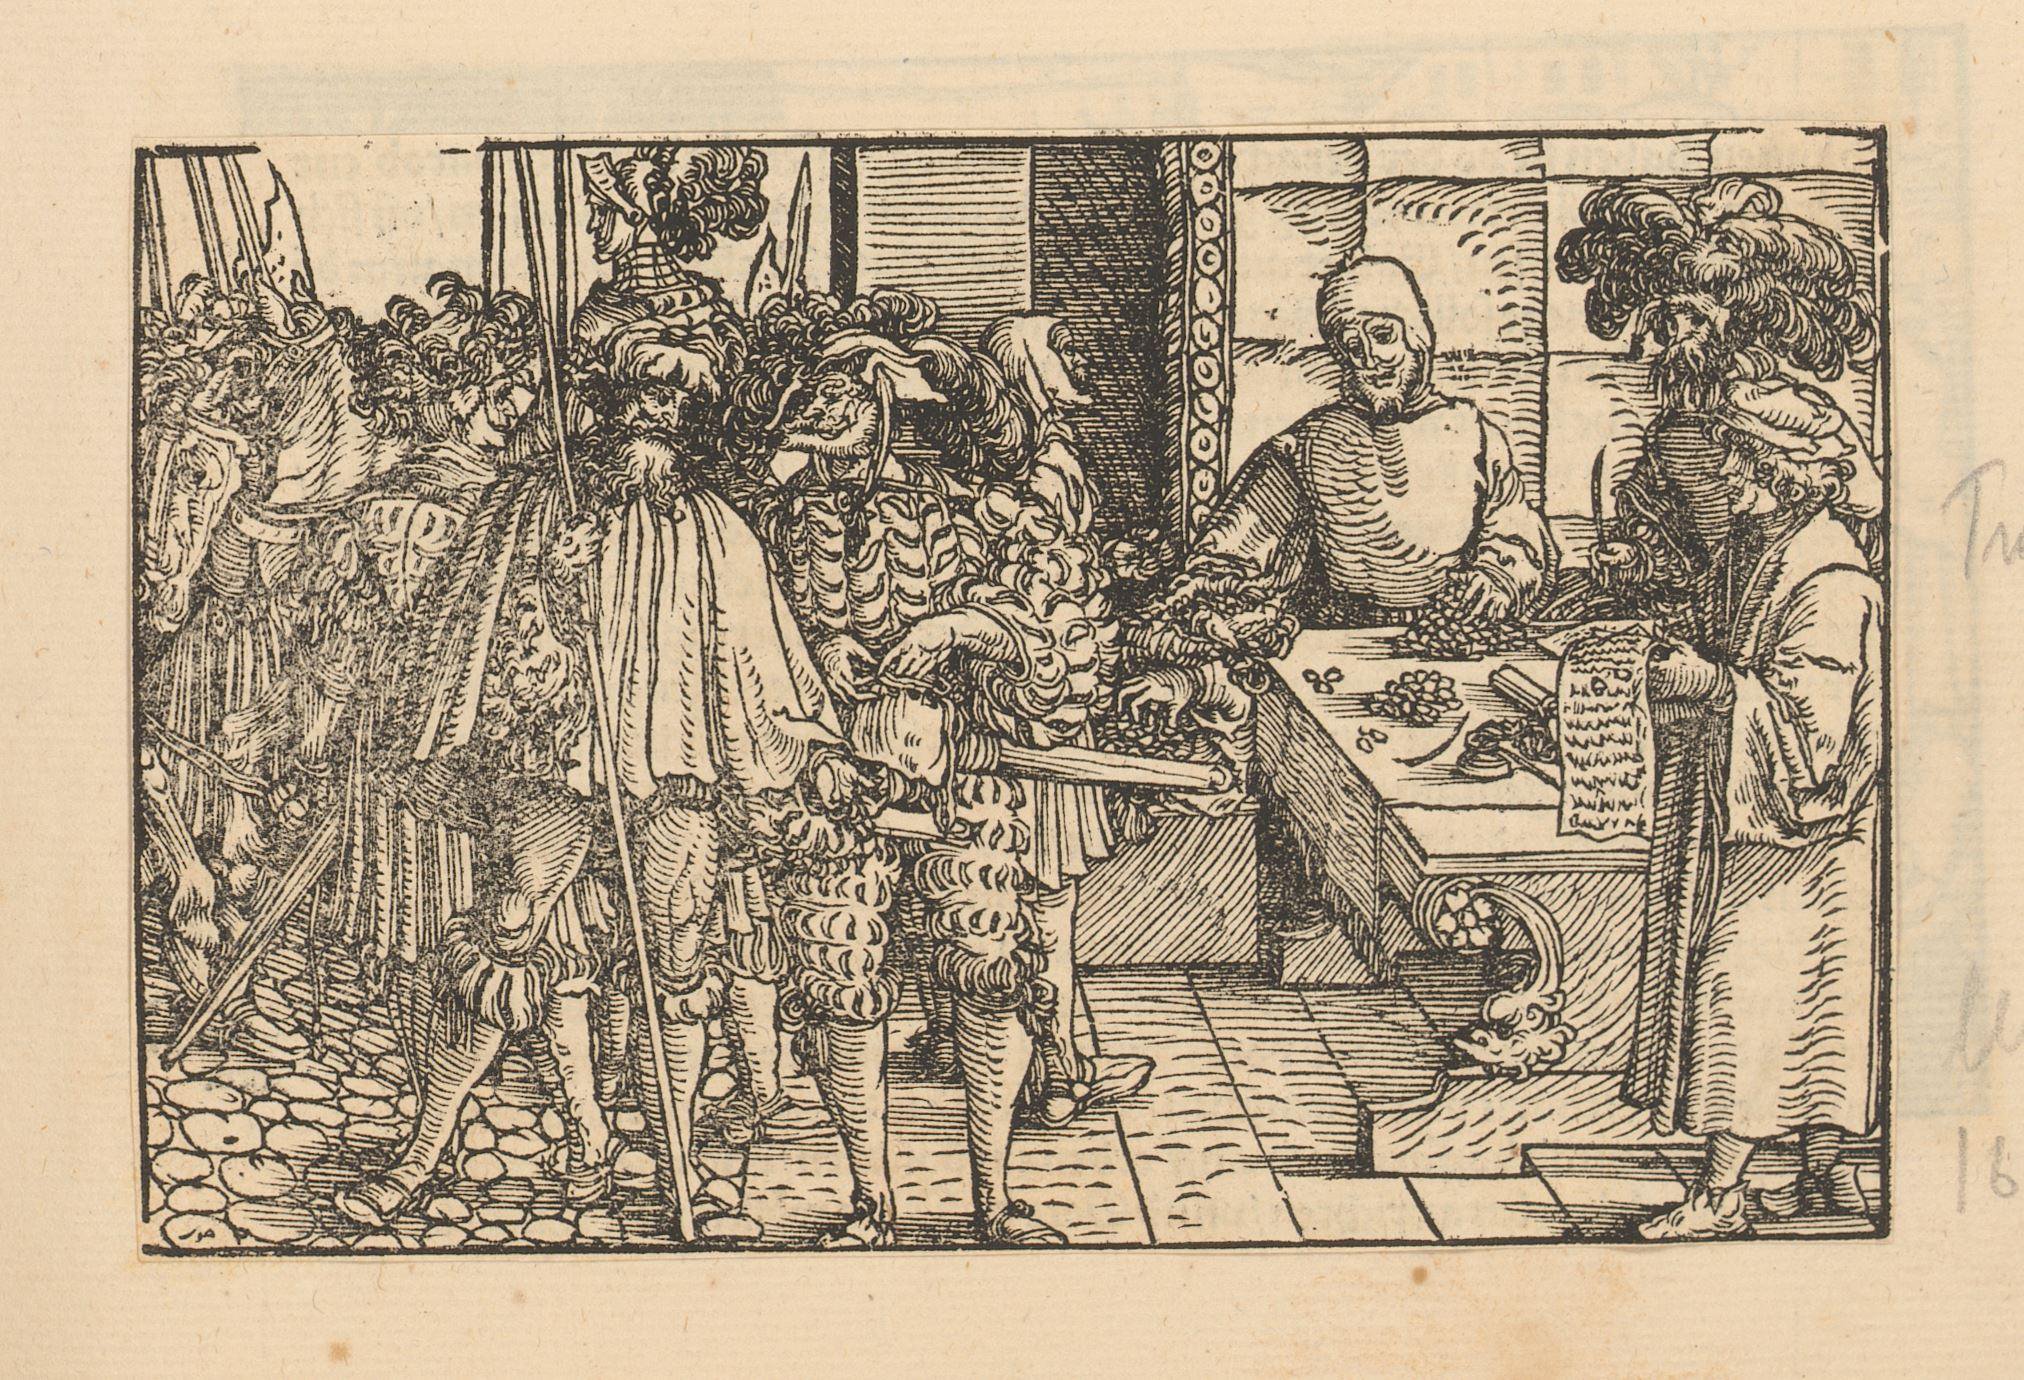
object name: album leaf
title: Ridders bij een woekeraar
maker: Anonymous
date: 1514-1532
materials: paper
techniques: letterpress printing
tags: dealing in money, knight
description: Deze prent is gebruikt in: Petrarca, Francesco. Von der Artzney bayder Glück, des guten und widerwertigen: unnd weß sich ain yeder inn Gelück und Unglück halten sol (...). Augsburg: Heinrich Steiner, 1532. Deze uitgave is ook bekend onder de titel 'Trostspiegel in Glück und Unglück'. In een andere staat van deze prent heeft de muntmeester een narrenkap op.